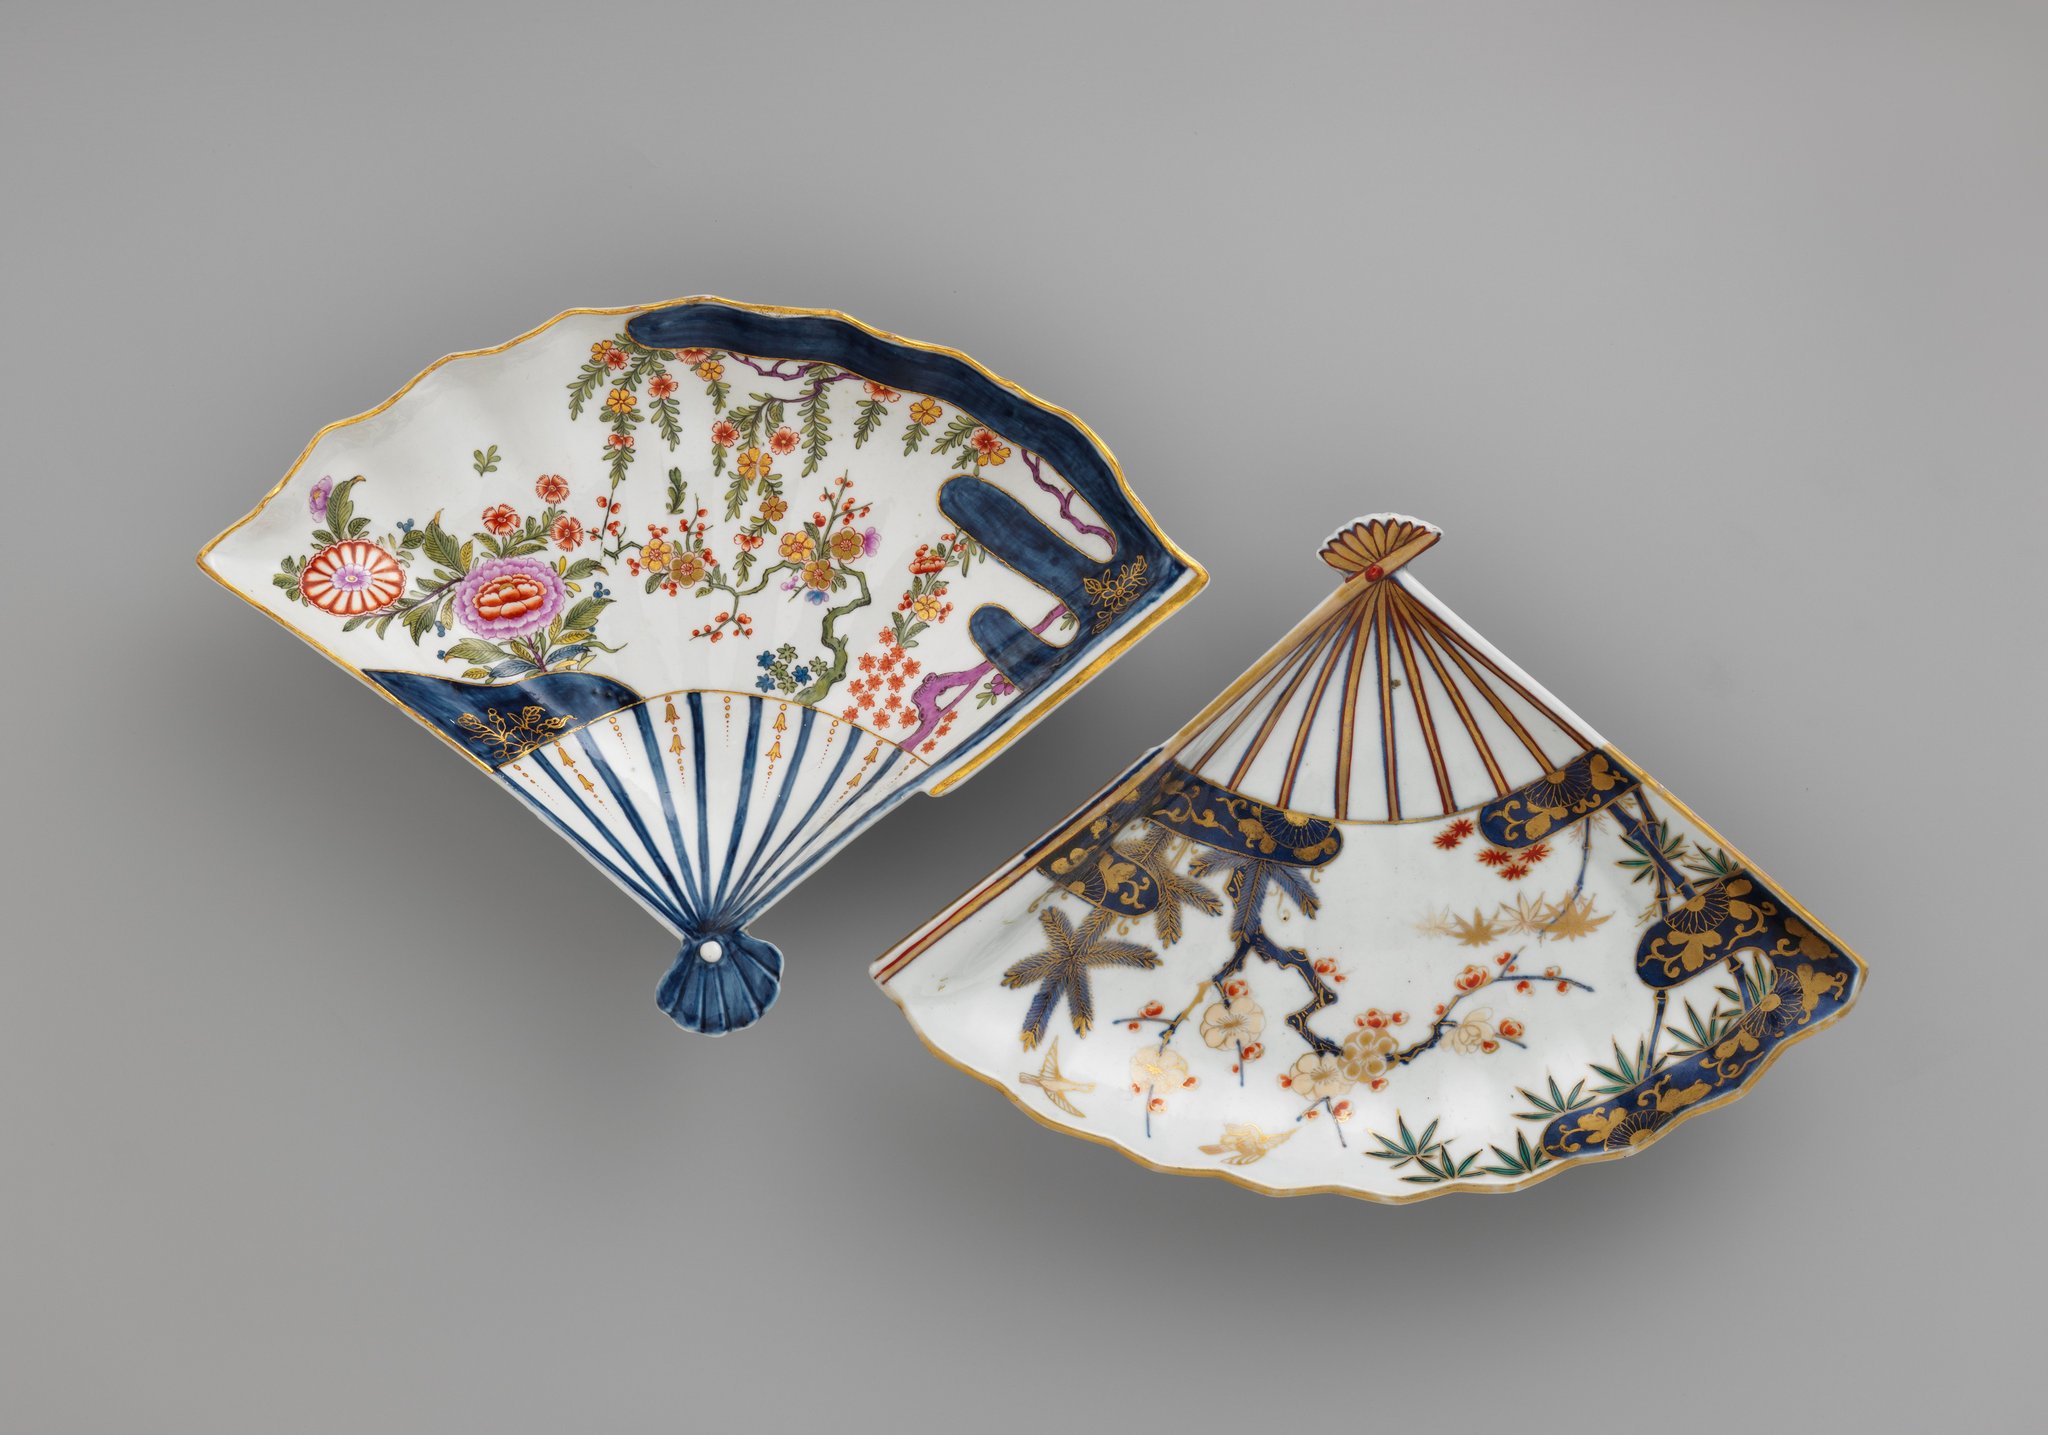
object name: dish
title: Fan-shaped dish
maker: vienna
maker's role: manufactory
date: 1725-1730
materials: enamel, glaze, hard paste porcelain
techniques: painting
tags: flowers